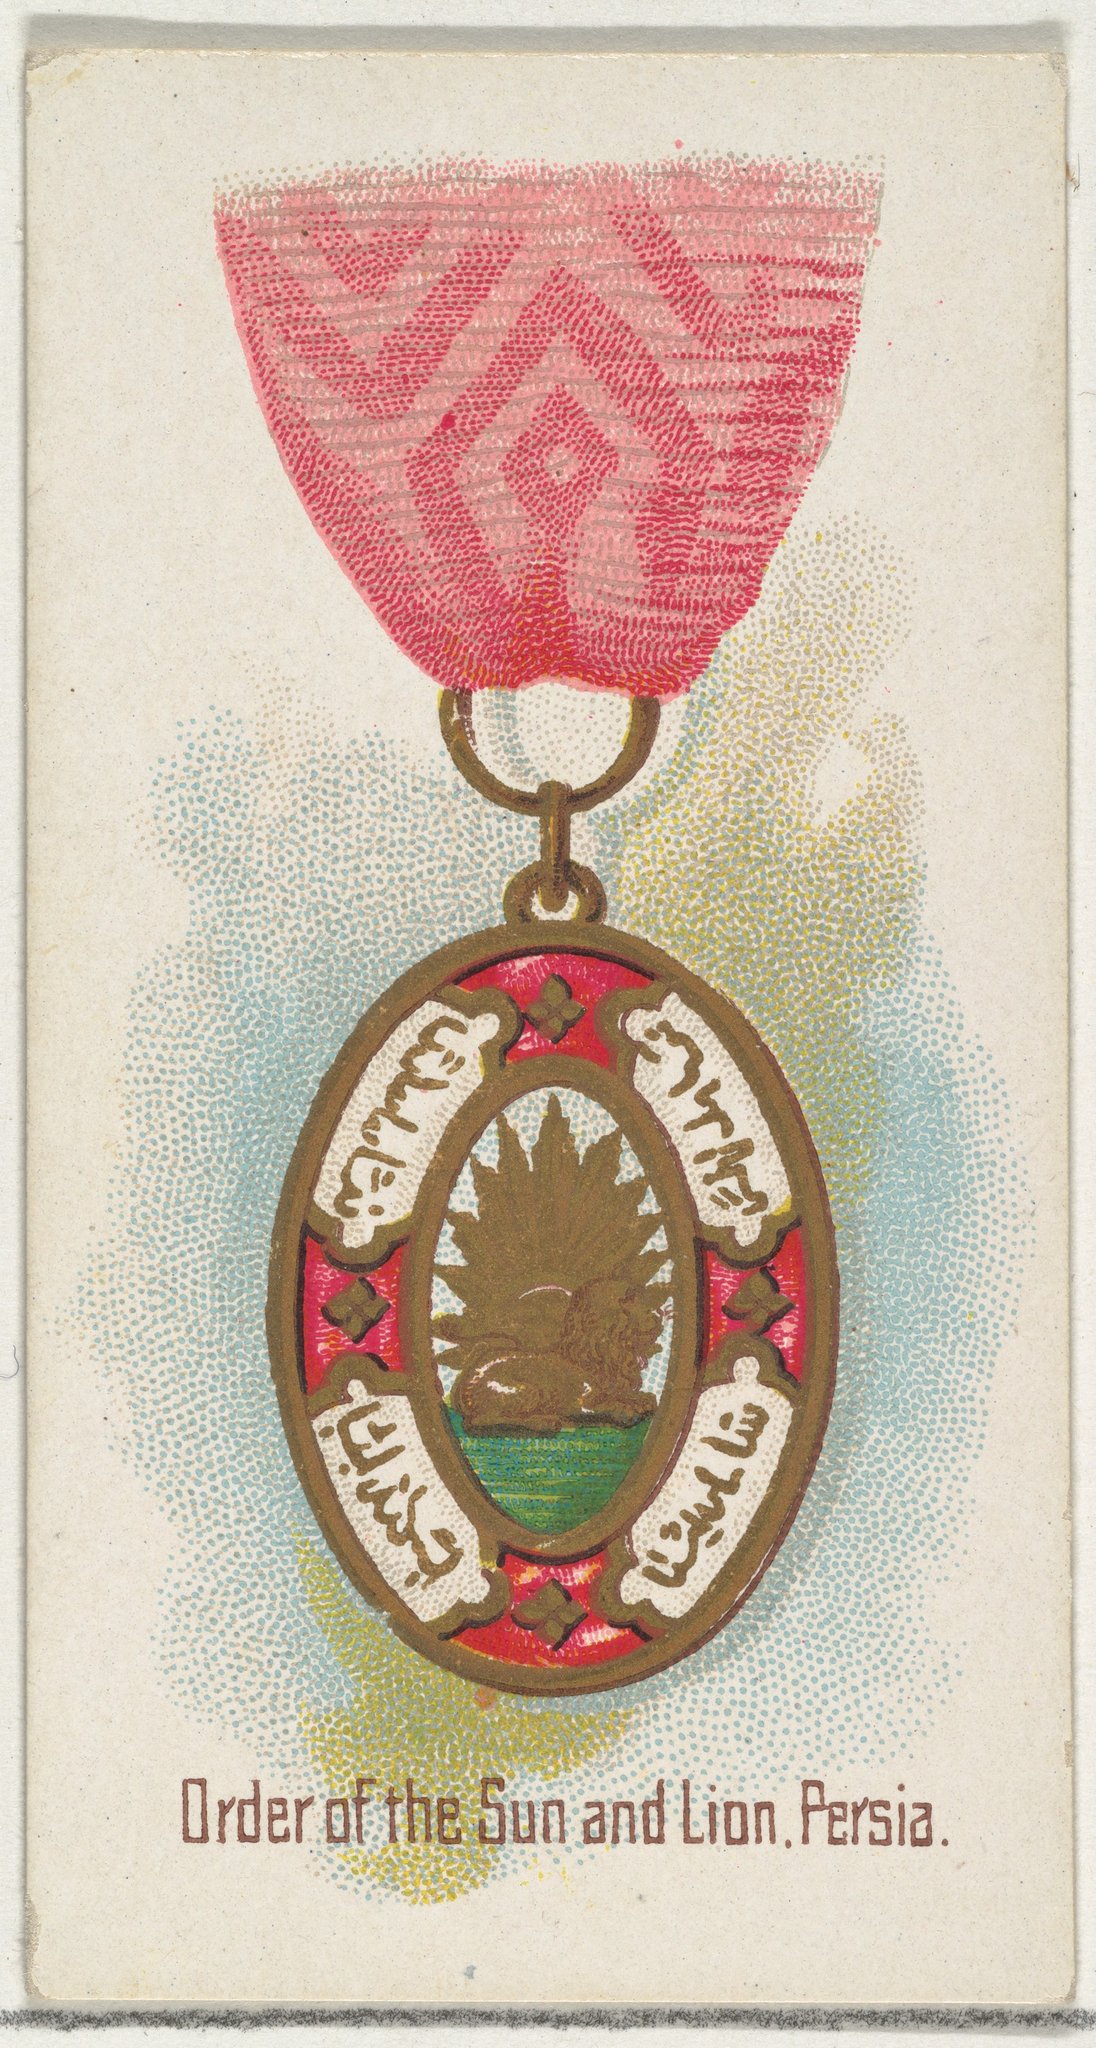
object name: print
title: Order of the Sun and Lion, Persia, from the World's Decorations series (N30) for Allen & Ginter Cigarettes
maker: allen & ginter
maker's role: publisher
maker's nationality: american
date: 1890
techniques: color lithograph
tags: medals